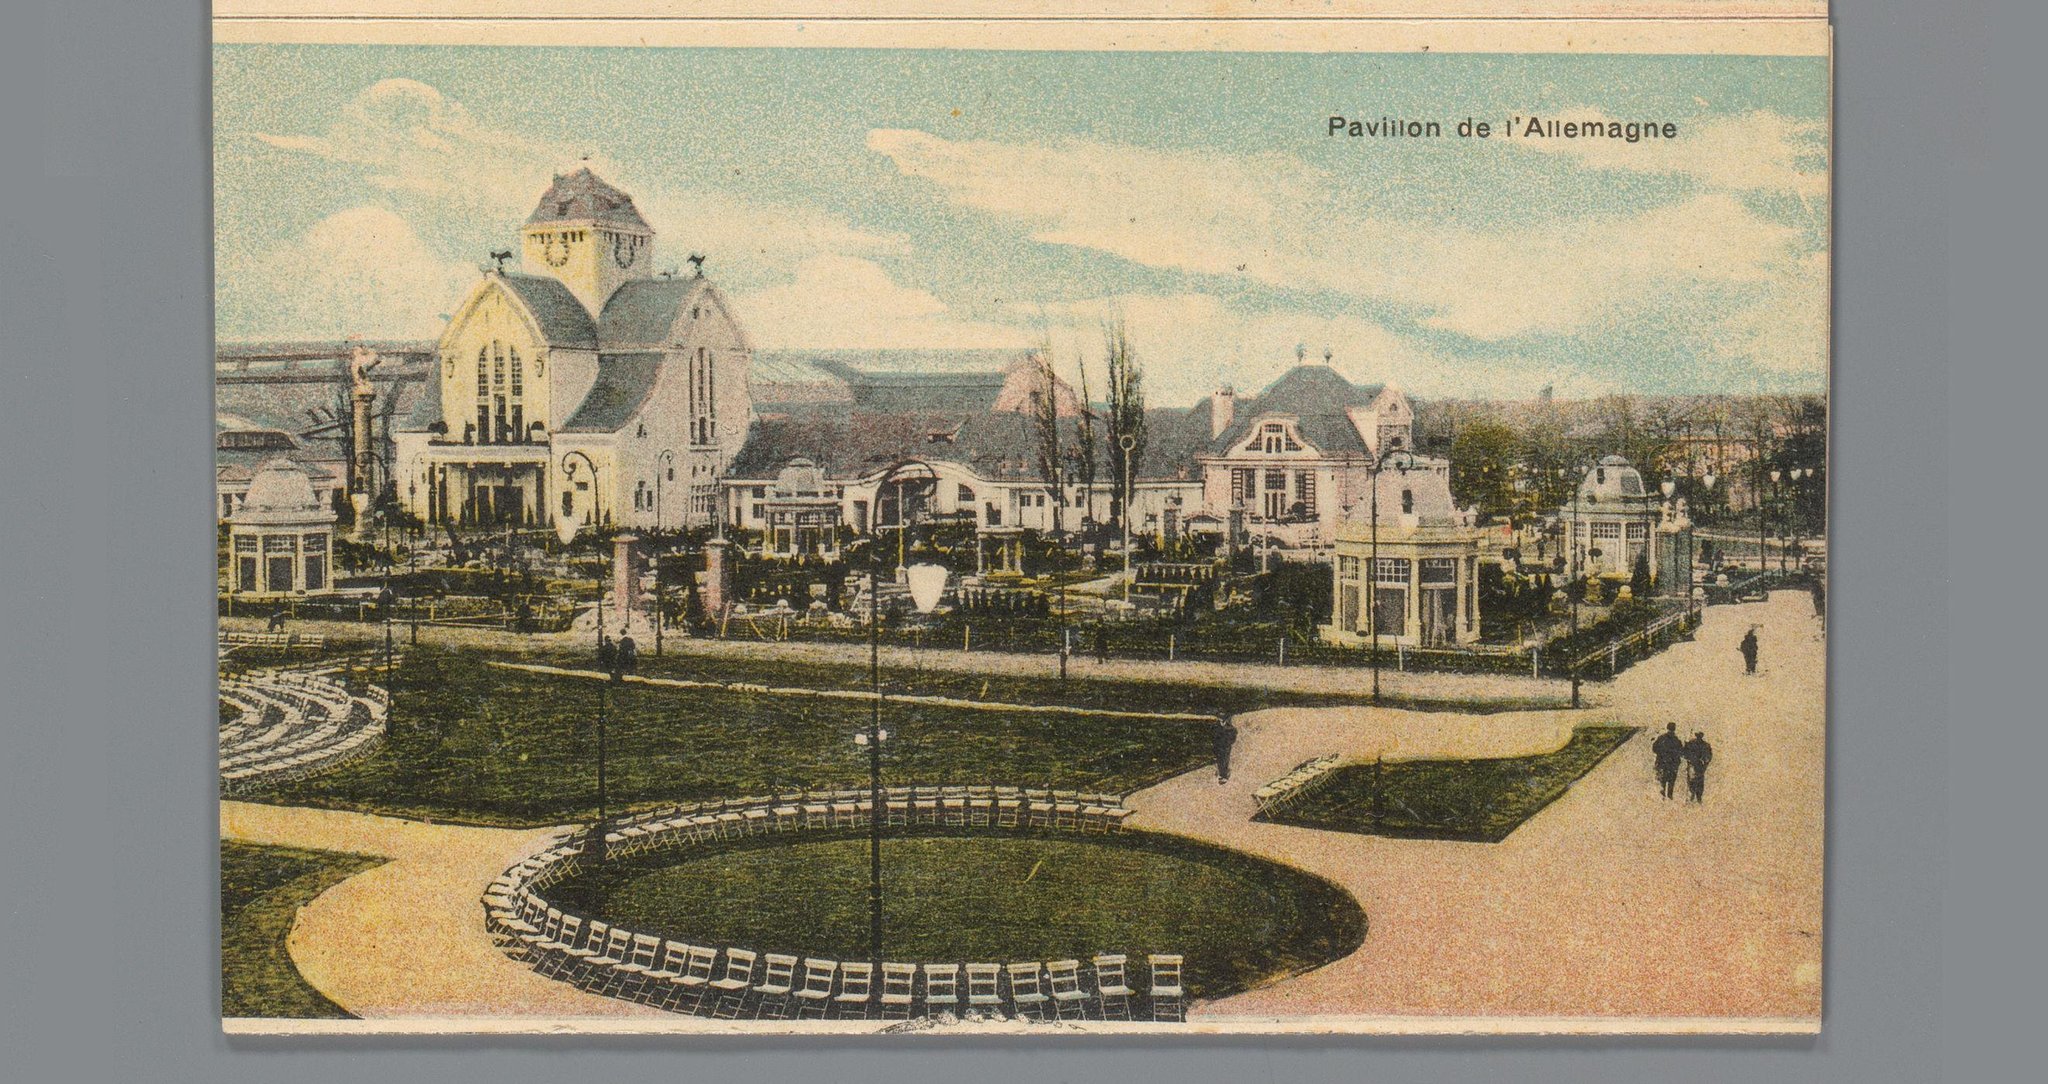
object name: ansichtkaart, prentbriefkaart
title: Pavillion de l'Allemagne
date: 1910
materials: cardboard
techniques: photograph, lithograph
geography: brussels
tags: park, world fair, world exhibition, prospect of city, town panorama, silhouette of city, brussels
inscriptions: date